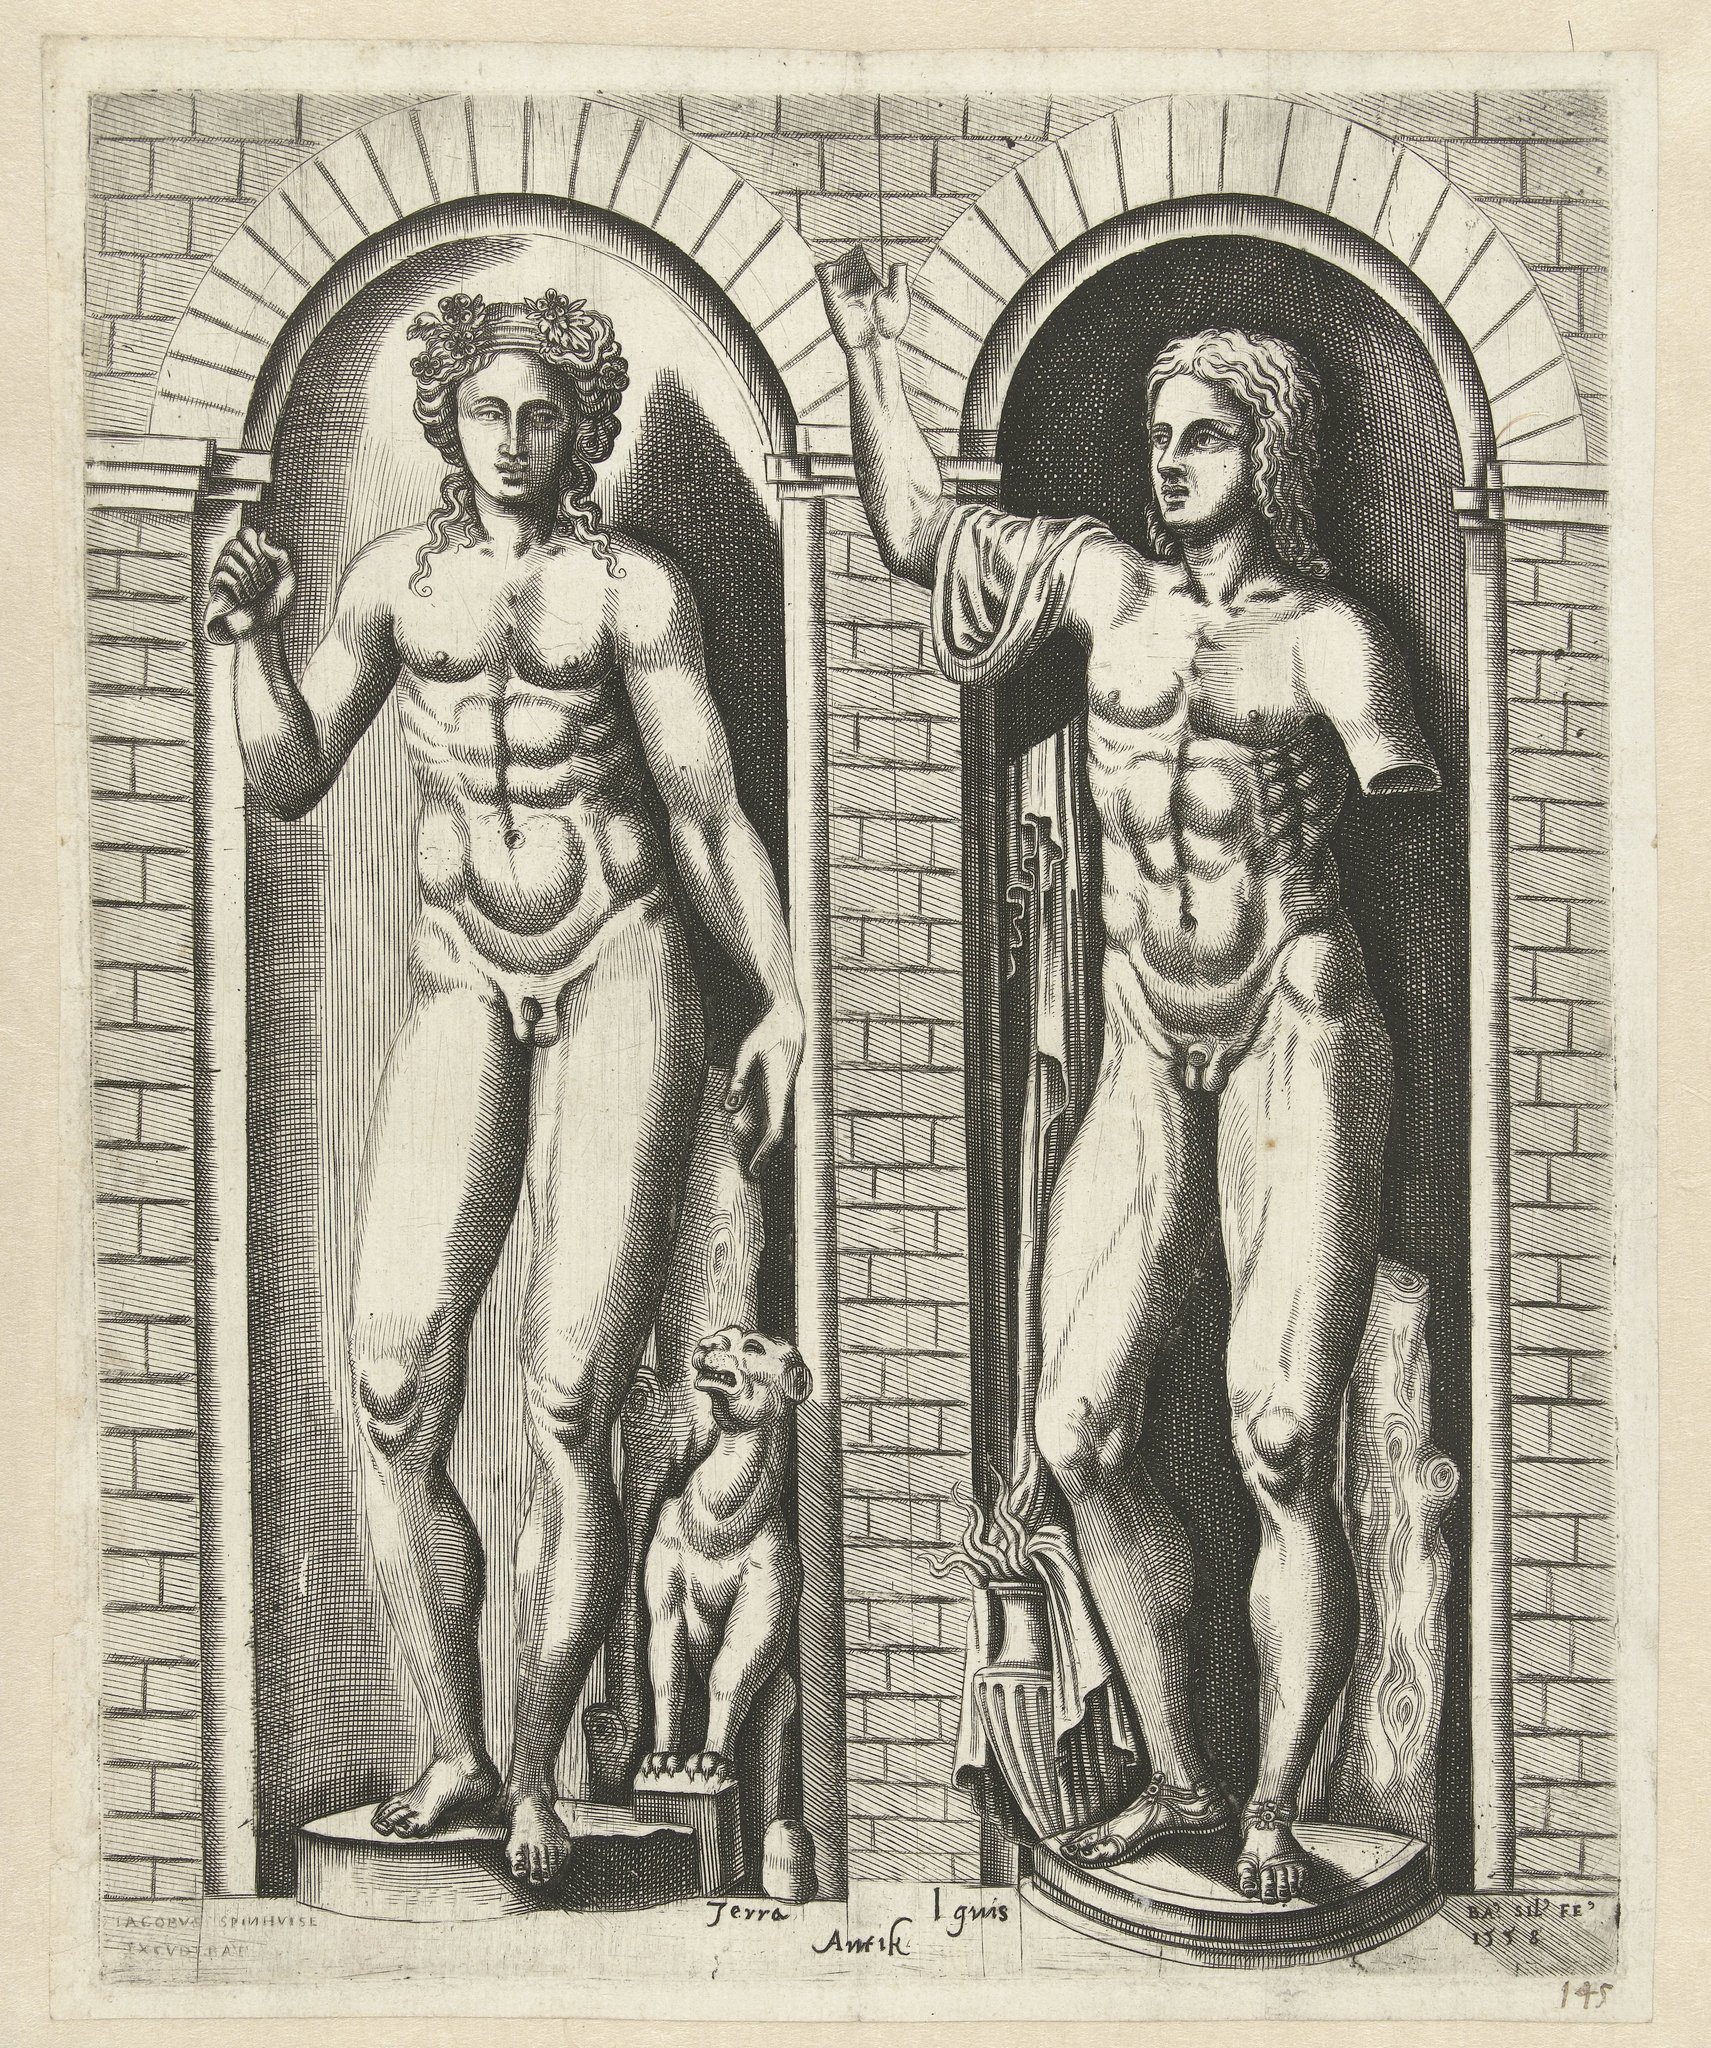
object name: print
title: Aarde en vuur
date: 1558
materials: paper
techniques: engraving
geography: antwerp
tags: earth (one of the four elements), fire (one of the four elements)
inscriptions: number, collector's mark: Lugt 2760, collector's mark: Lugt 2228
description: Twee arcades met beelden. Links de personificatie van aarde en rechts de personificatie van vuur. Aarde is een naakte man met bloemen in het haar. Een leeuw en een boomstronk bevinden zich naast zijn voeten. Vuur is een naakte jongeling. Zijn rechtervingers en linkerarm ontbreken. Naast hem staat een vuurpot.